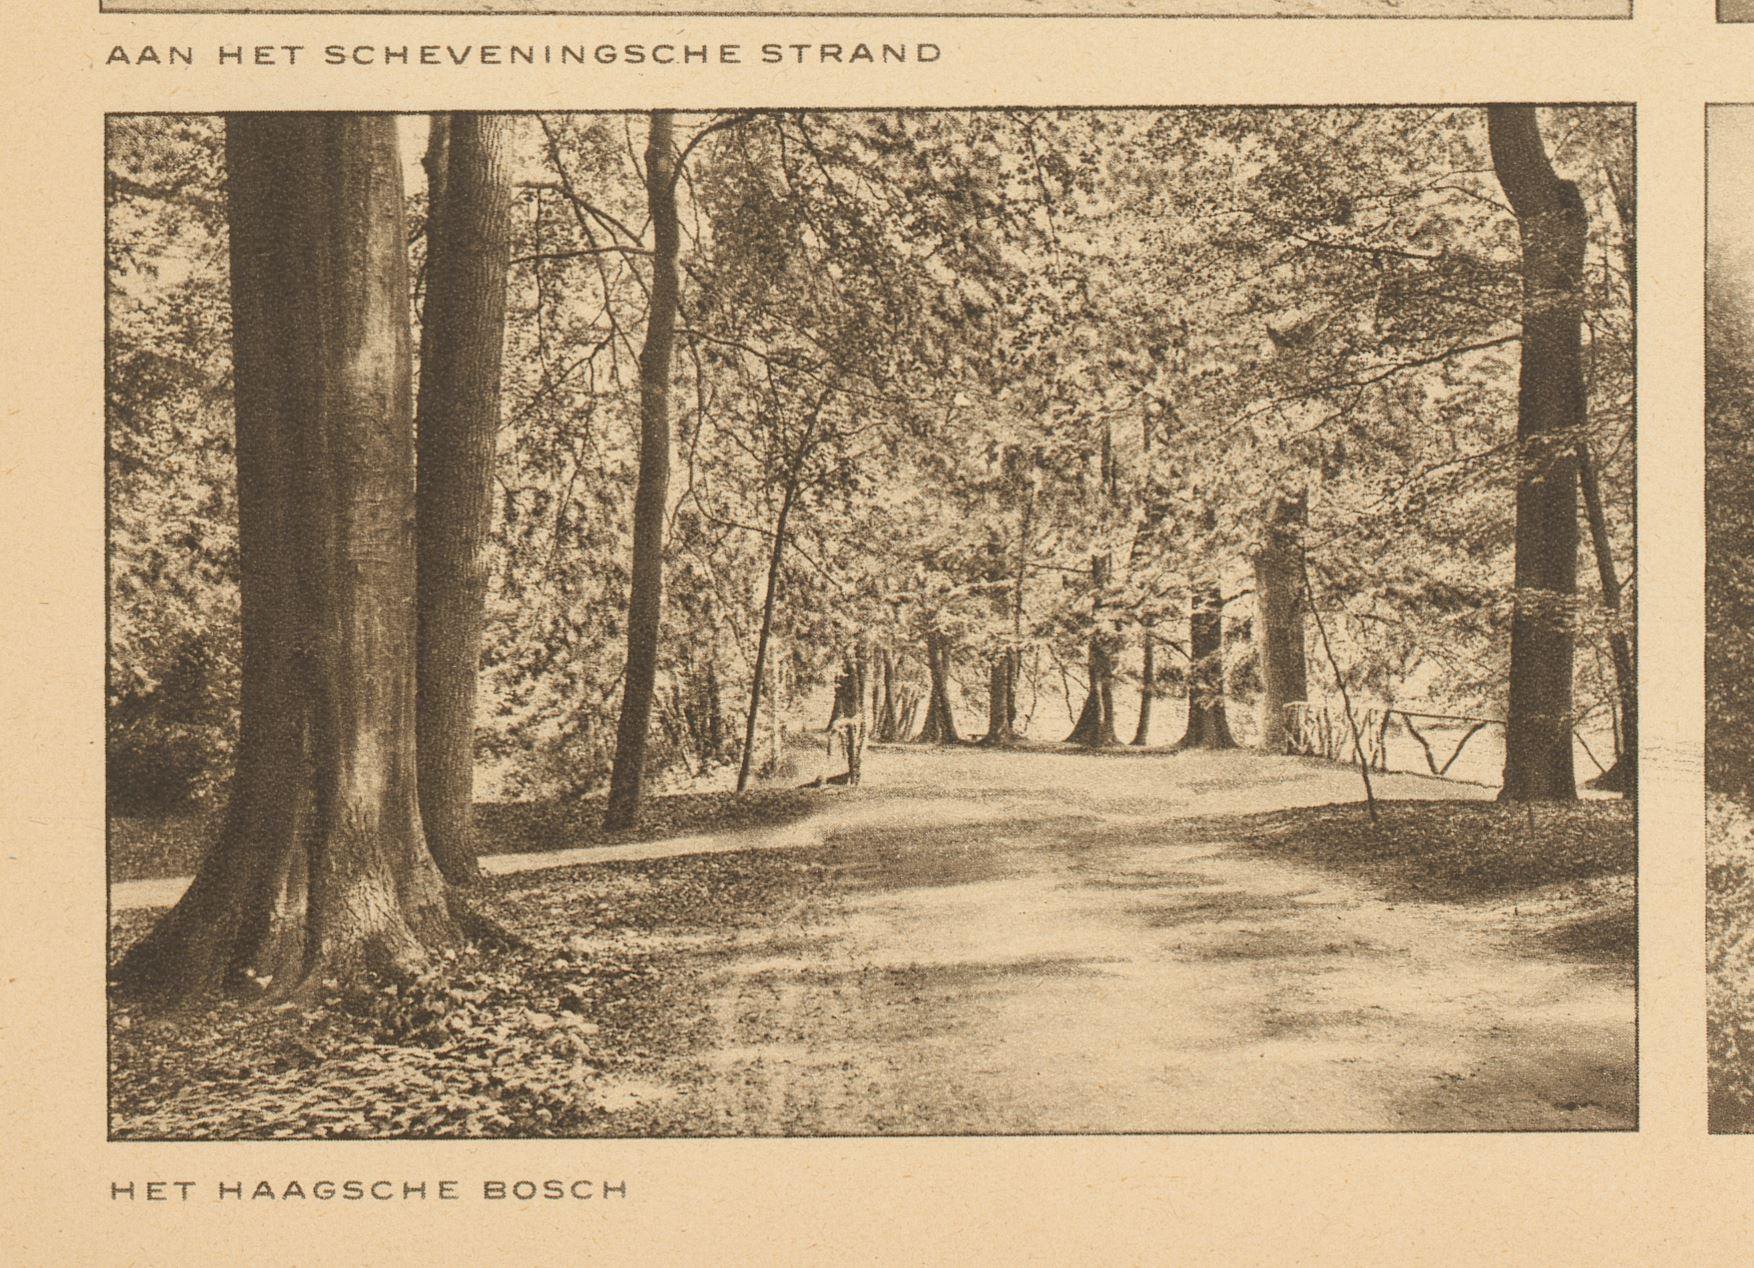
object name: photomechanical print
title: Het Haagsche Bosch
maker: Anonymous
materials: paper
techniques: rotogravure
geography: haagse bos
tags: forest path or lane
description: Deze prent maakt deel uit van een album.